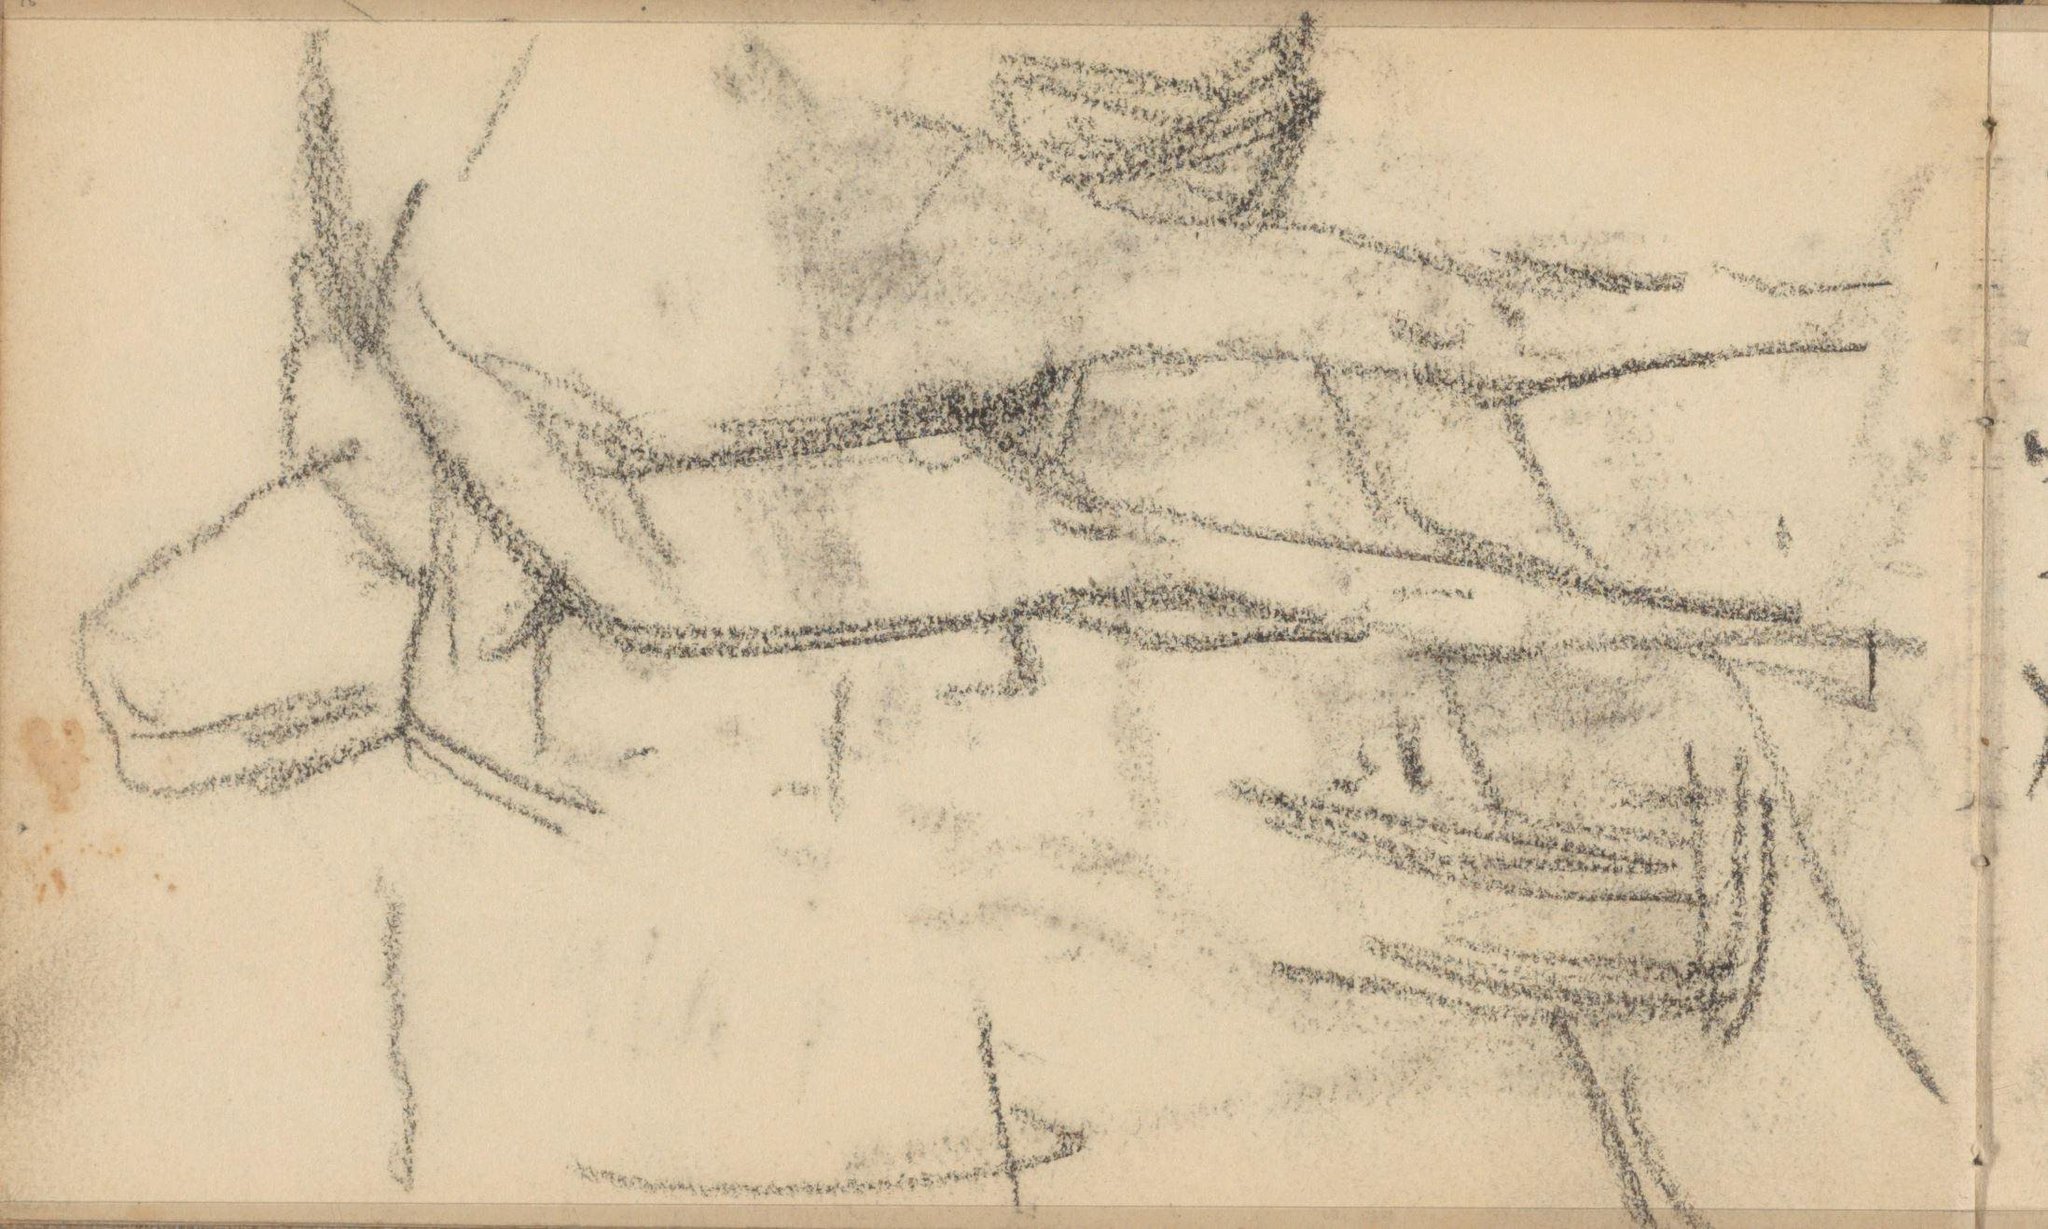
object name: sketchbook leaf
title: Soldaat bij een paard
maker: george hendrik breitner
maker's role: draughtsman, painter, print maker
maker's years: 1857-1923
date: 1884-1886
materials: chalk, paper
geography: the hague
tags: land forces (+ artillery), horse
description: Mogelijk een artillerist. Pagina 15 uit een schetsboek met 35 bladen.